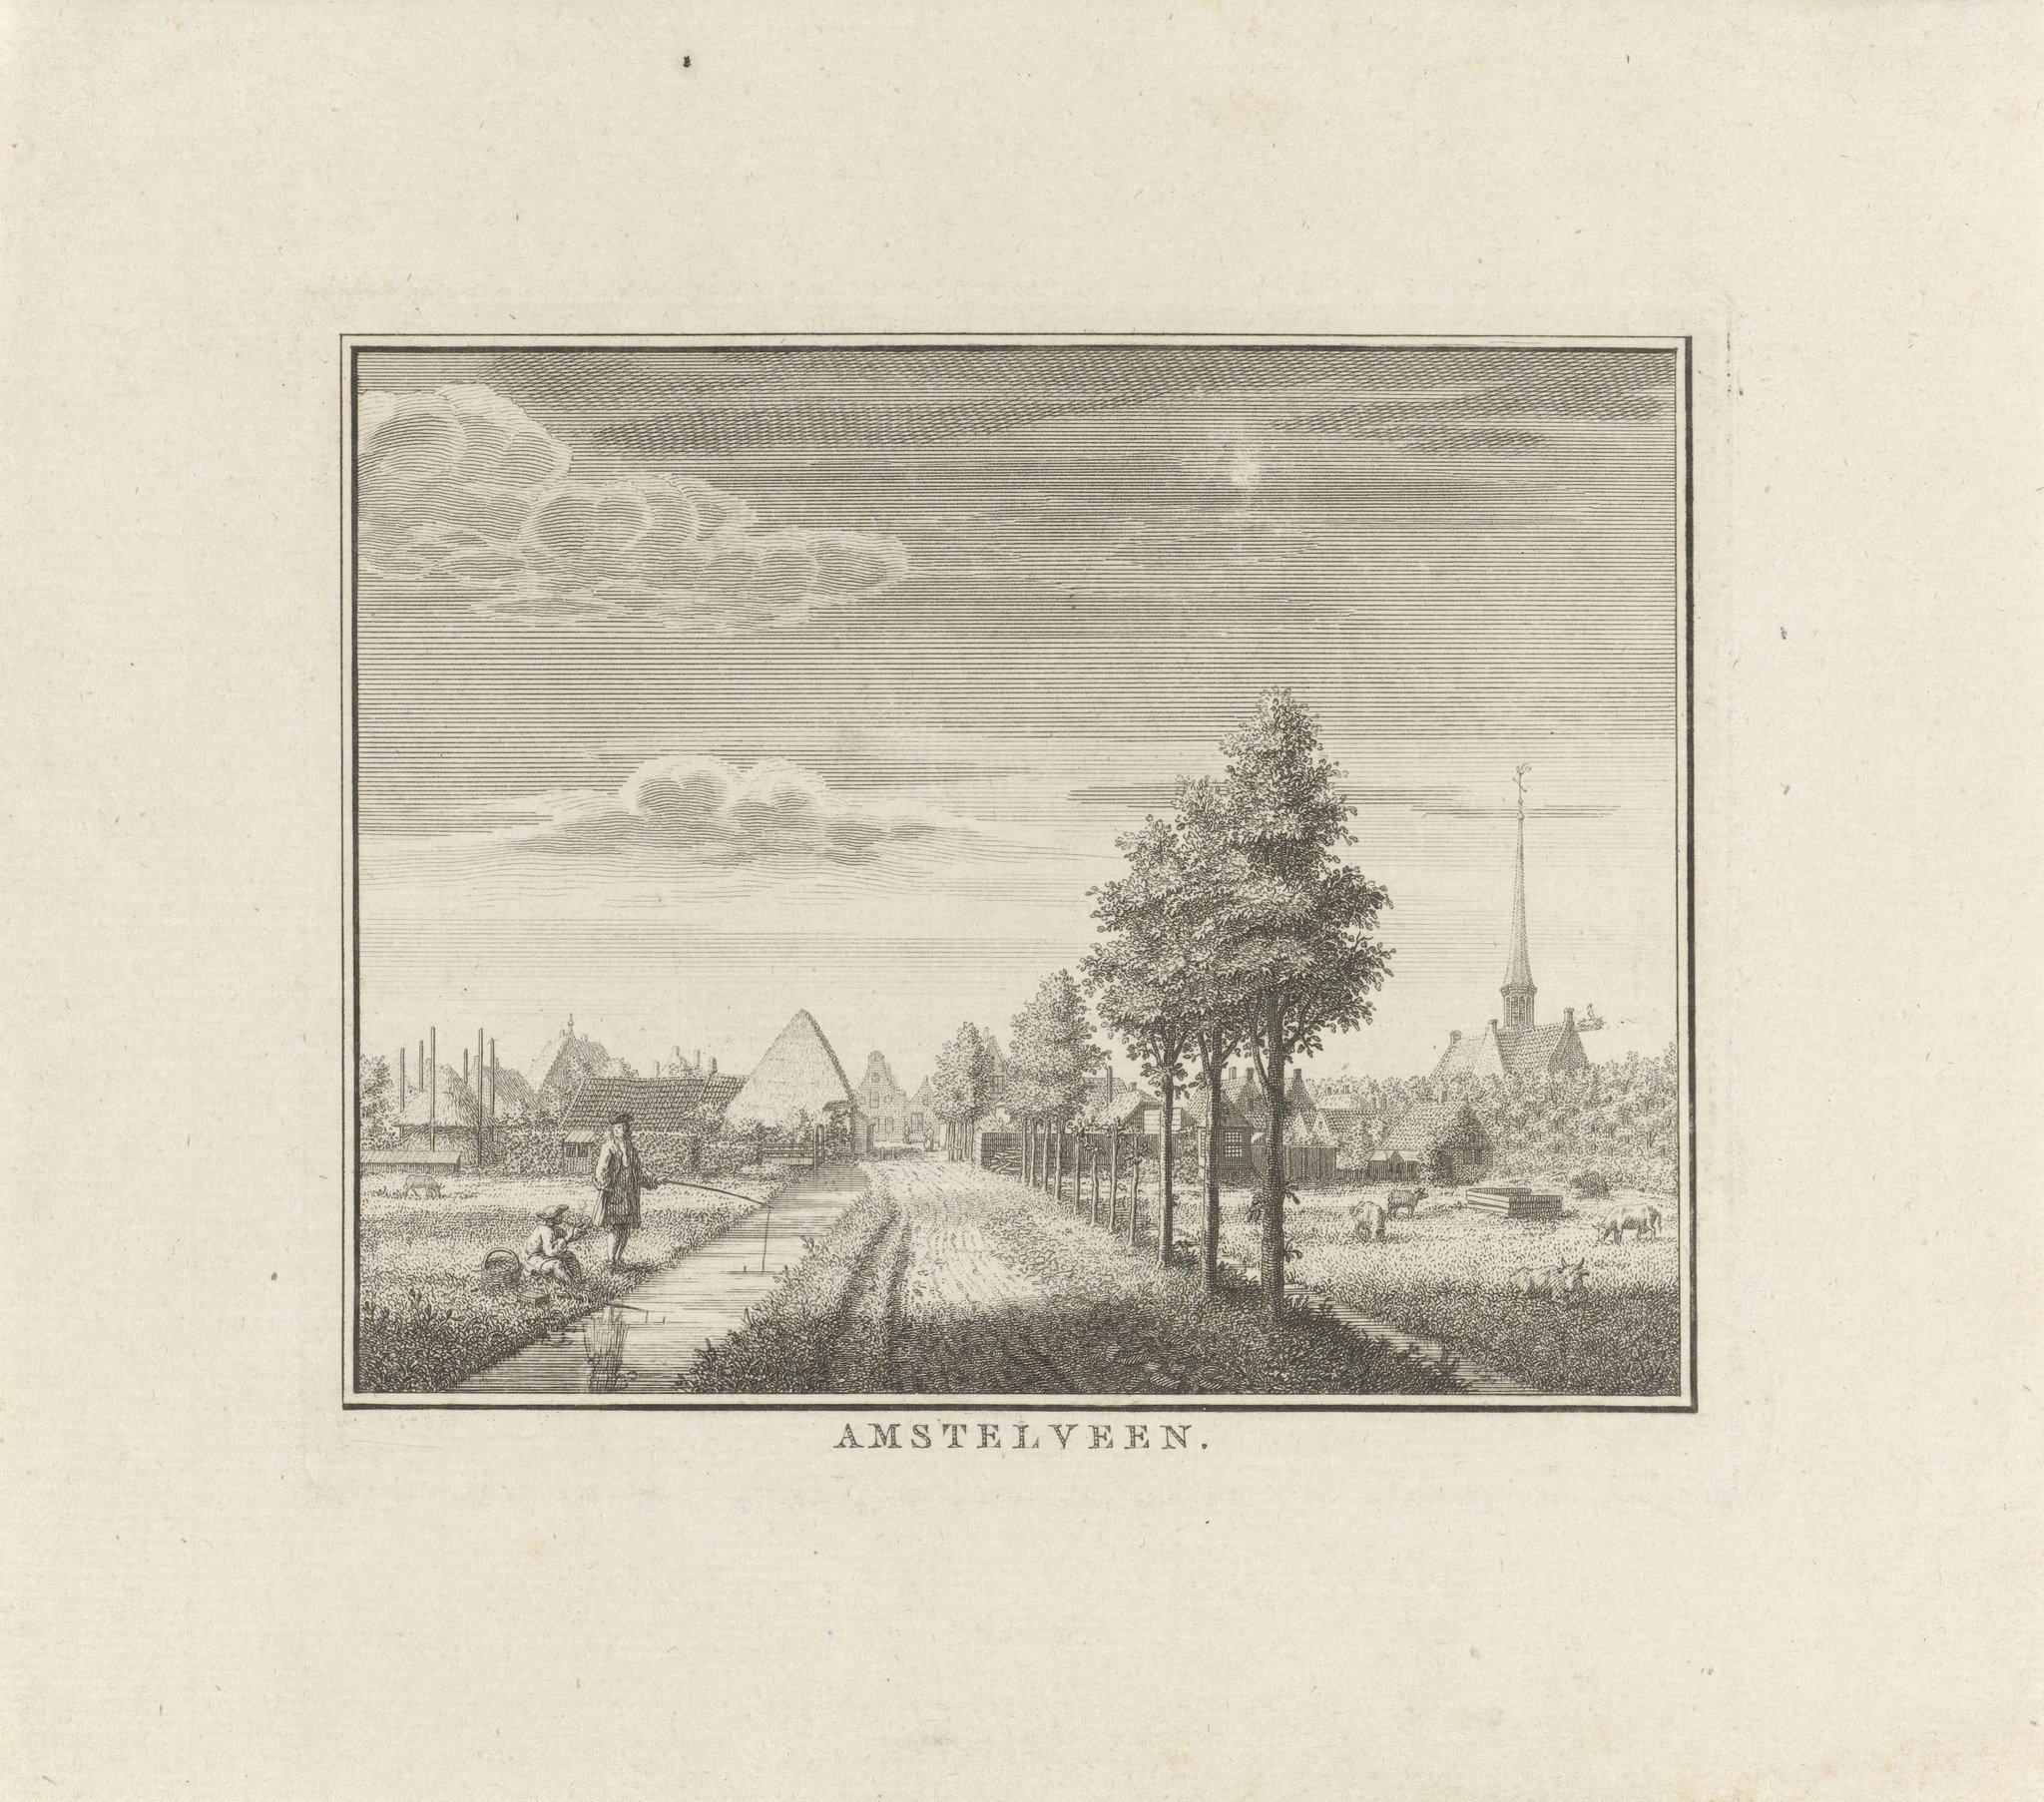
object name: print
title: Amstelveen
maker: jan caspar philips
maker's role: draughtsman, print maker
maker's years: 1700-1775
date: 1736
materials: paper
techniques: etching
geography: amsterdam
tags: meadow, pasture, church (exterior), fisherman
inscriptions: collector's mark: Lugt 2228